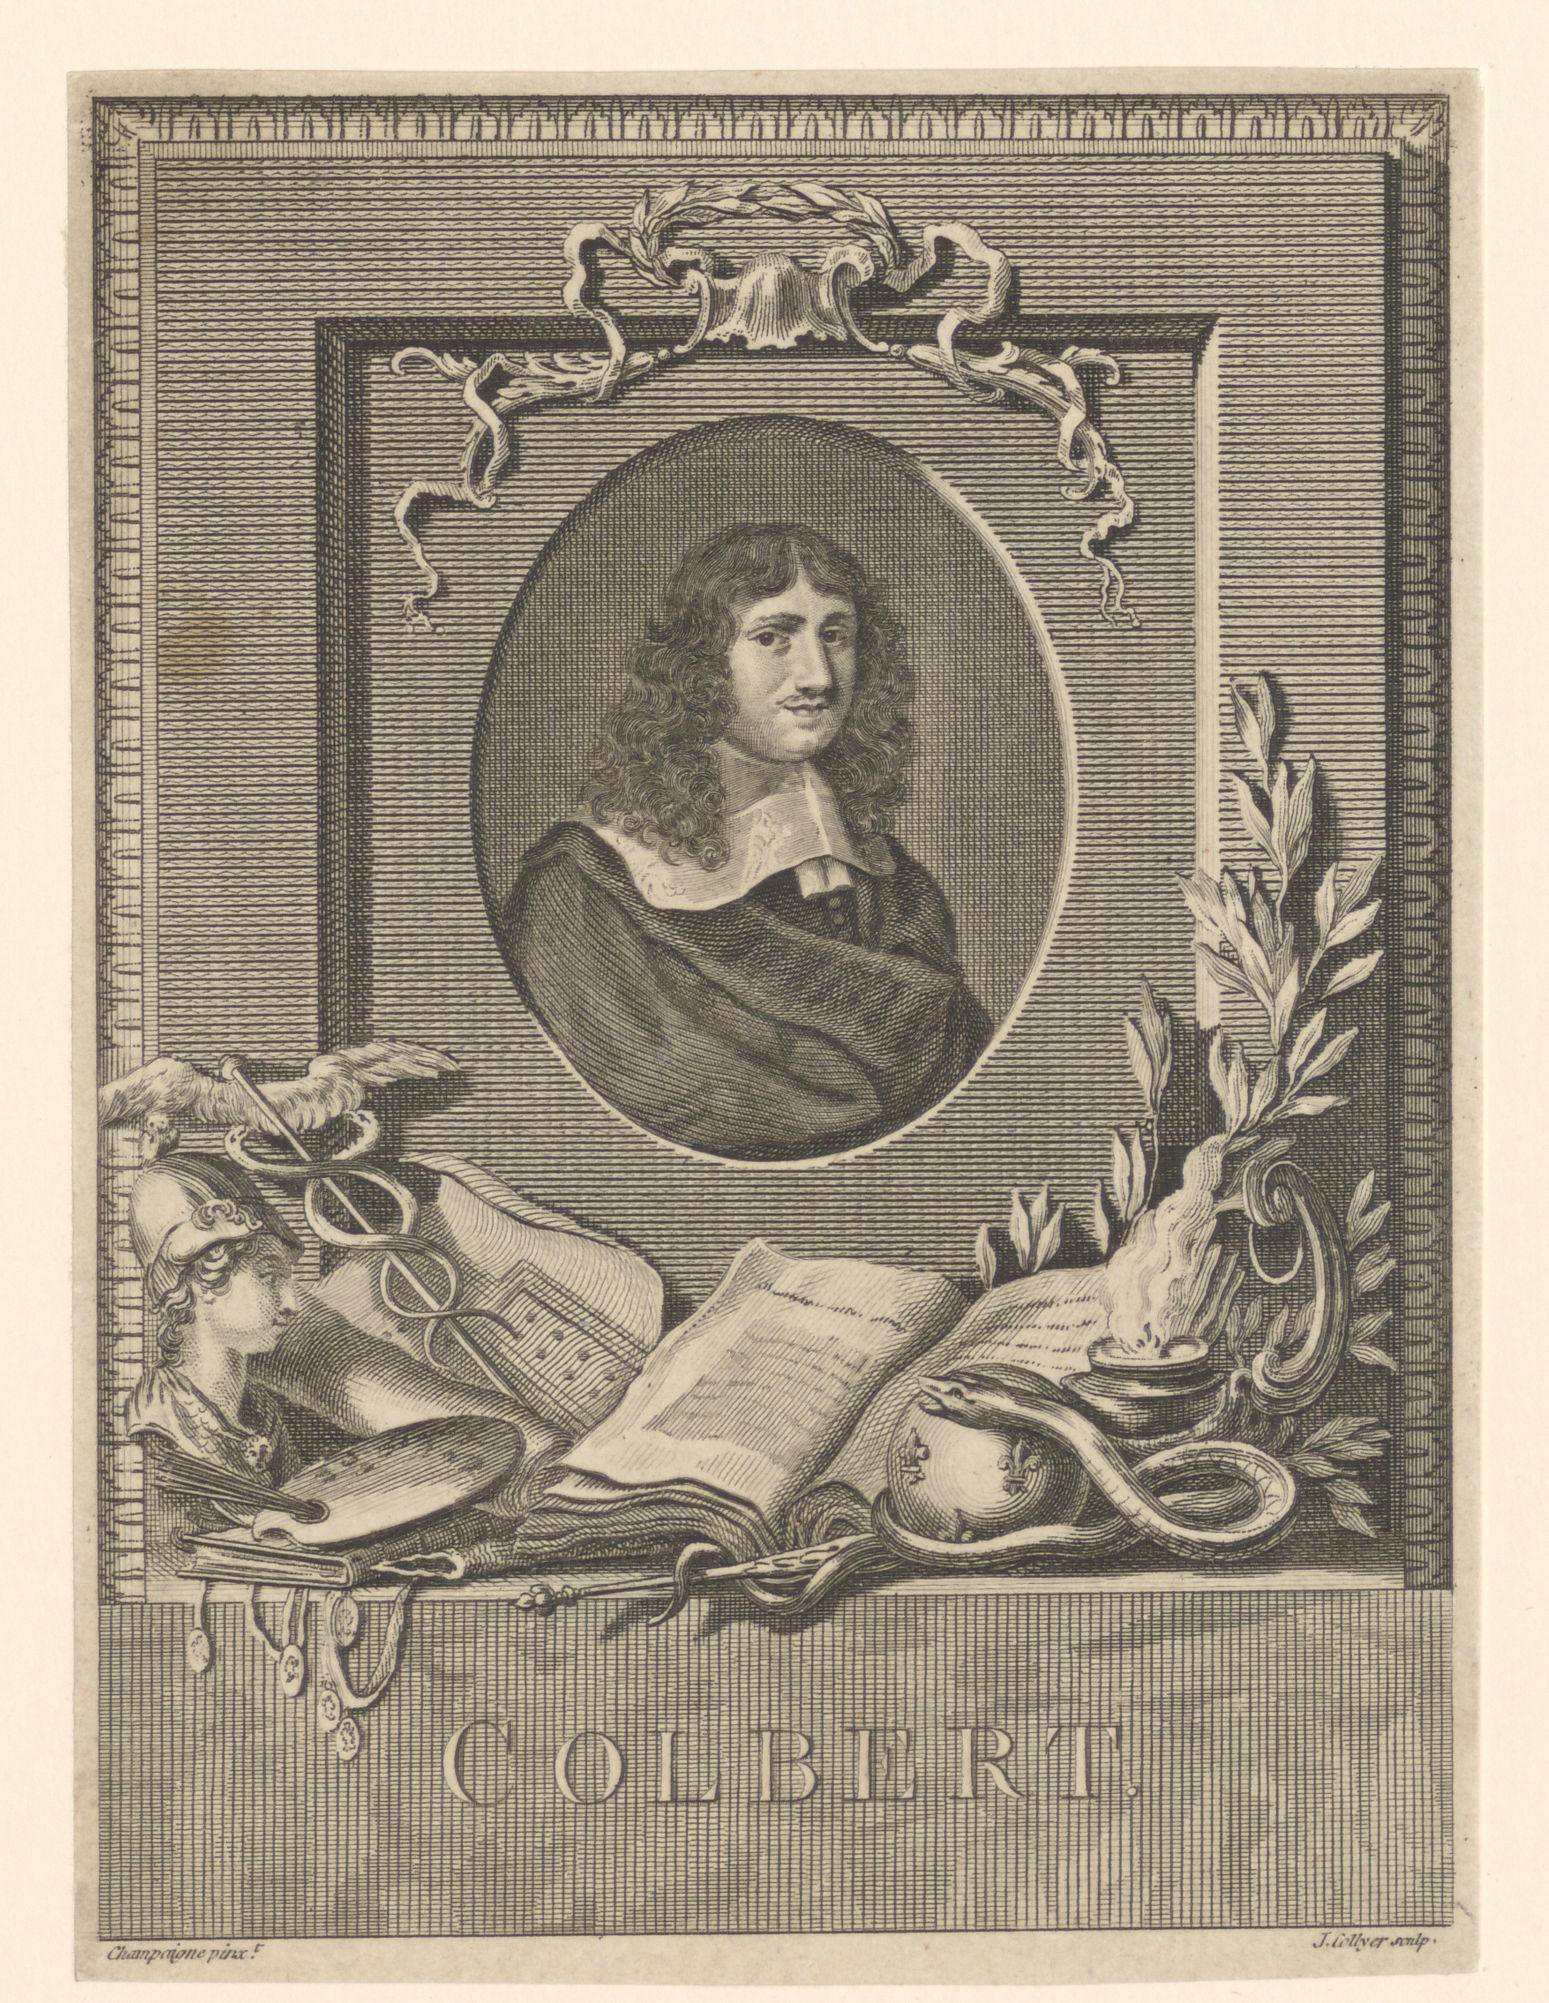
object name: print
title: Portret van Jean-Baptiste Colbert de Seignelay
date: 1758-1774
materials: paper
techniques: engraving, etching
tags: politician, jean-baptiste colbert de seignelay, historical persons, politician, e.g. party leader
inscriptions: collector's mark: Lugt 2228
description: Prent gebruikt in: The Copper-Plate Magazine or A Monthly Treasure (1774).